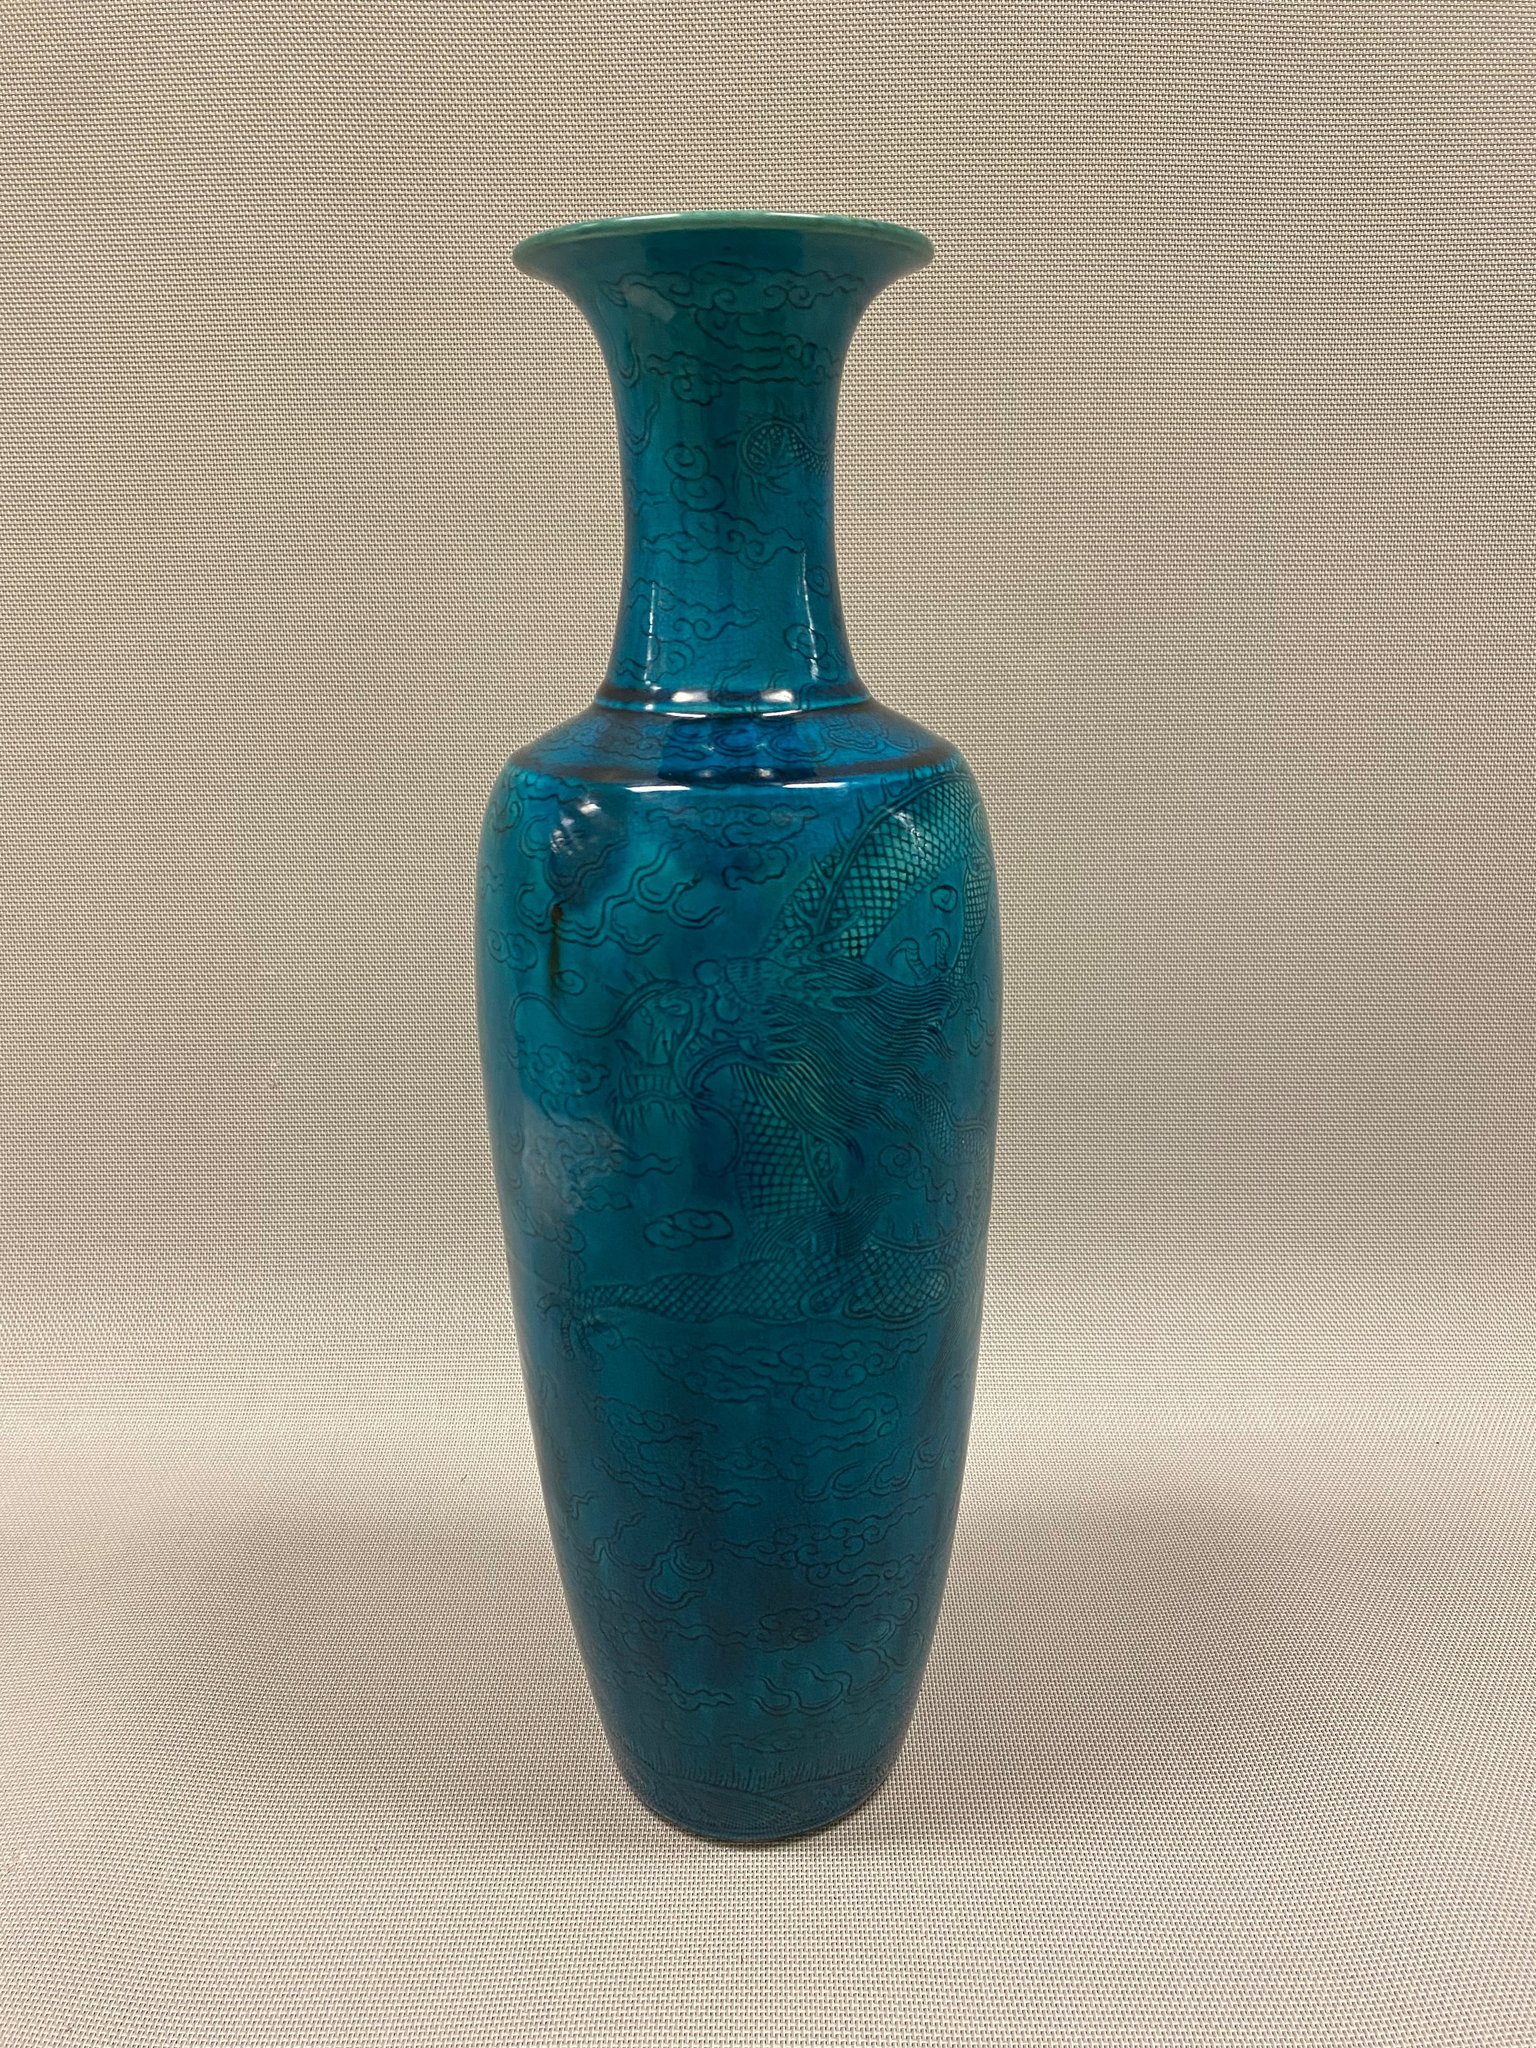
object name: vase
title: Vase with dragon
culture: chinese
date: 1767-1800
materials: glaze, porcelain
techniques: incising